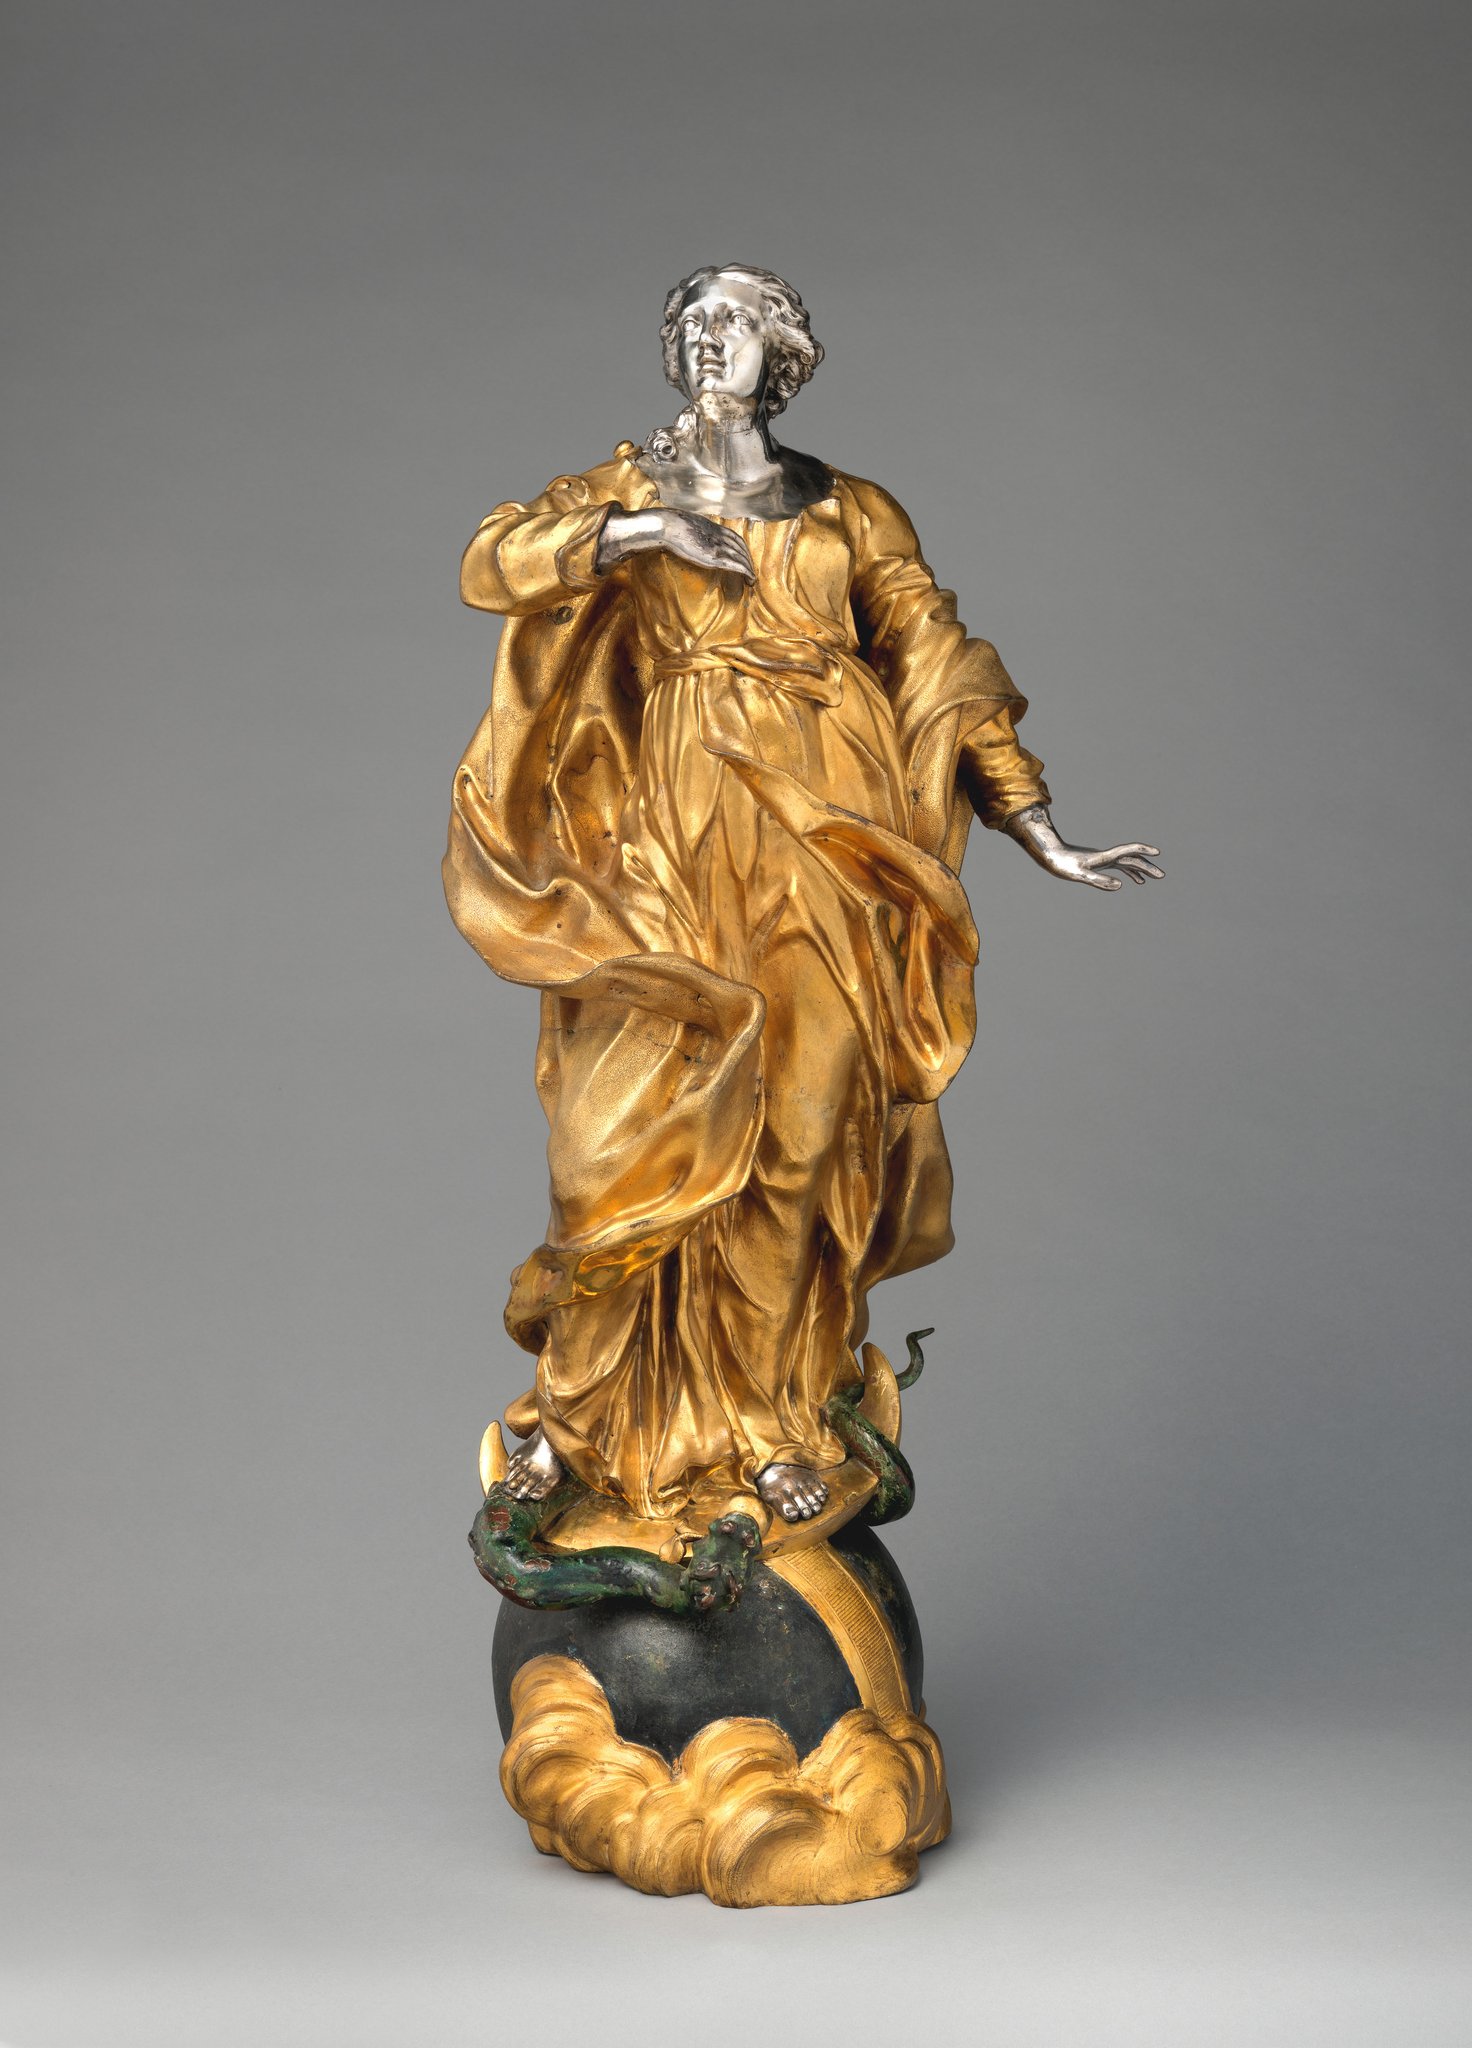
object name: statuette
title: Virgin of the Immaculate Conception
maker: lorenzo vaccaro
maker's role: artist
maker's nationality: italian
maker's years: 1653-1706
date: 1667-1700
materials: bronze, gilt, silver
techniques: polychromy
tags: virgin mary